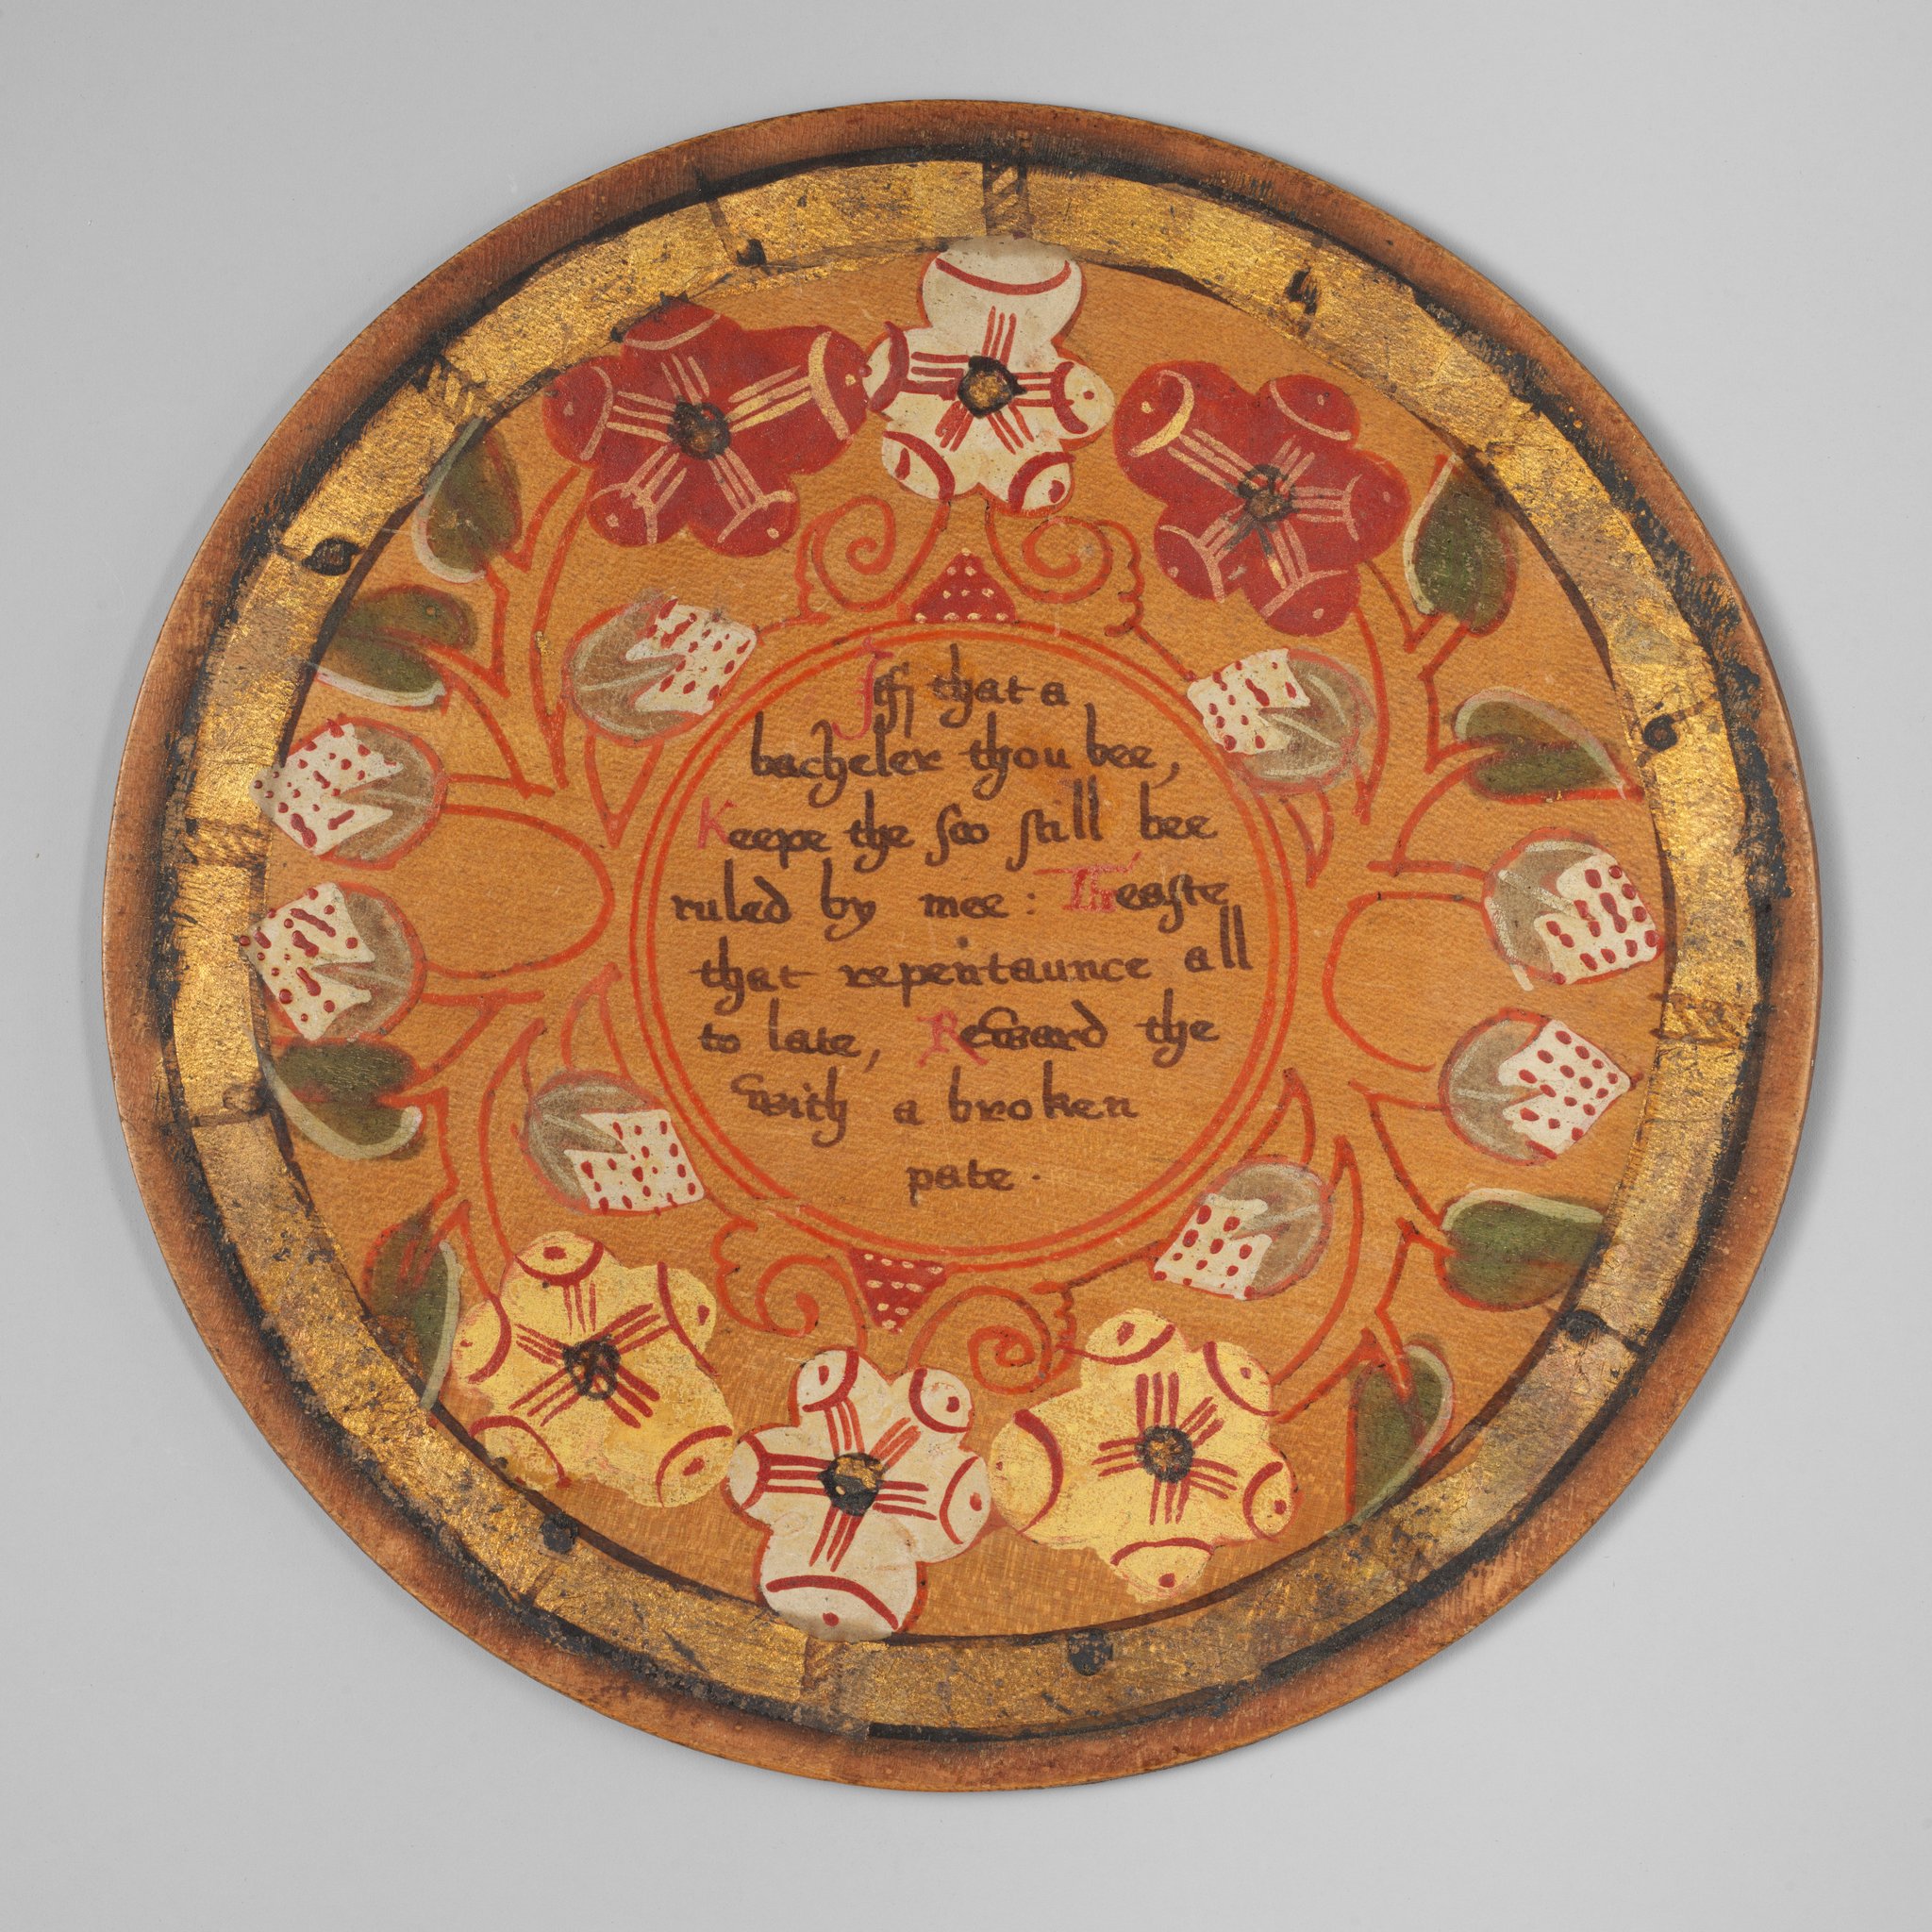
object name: trencher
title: Trencher (one of a set)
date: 1567-1633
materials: ink, wood, varnish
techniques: painting, silvered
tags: flowers